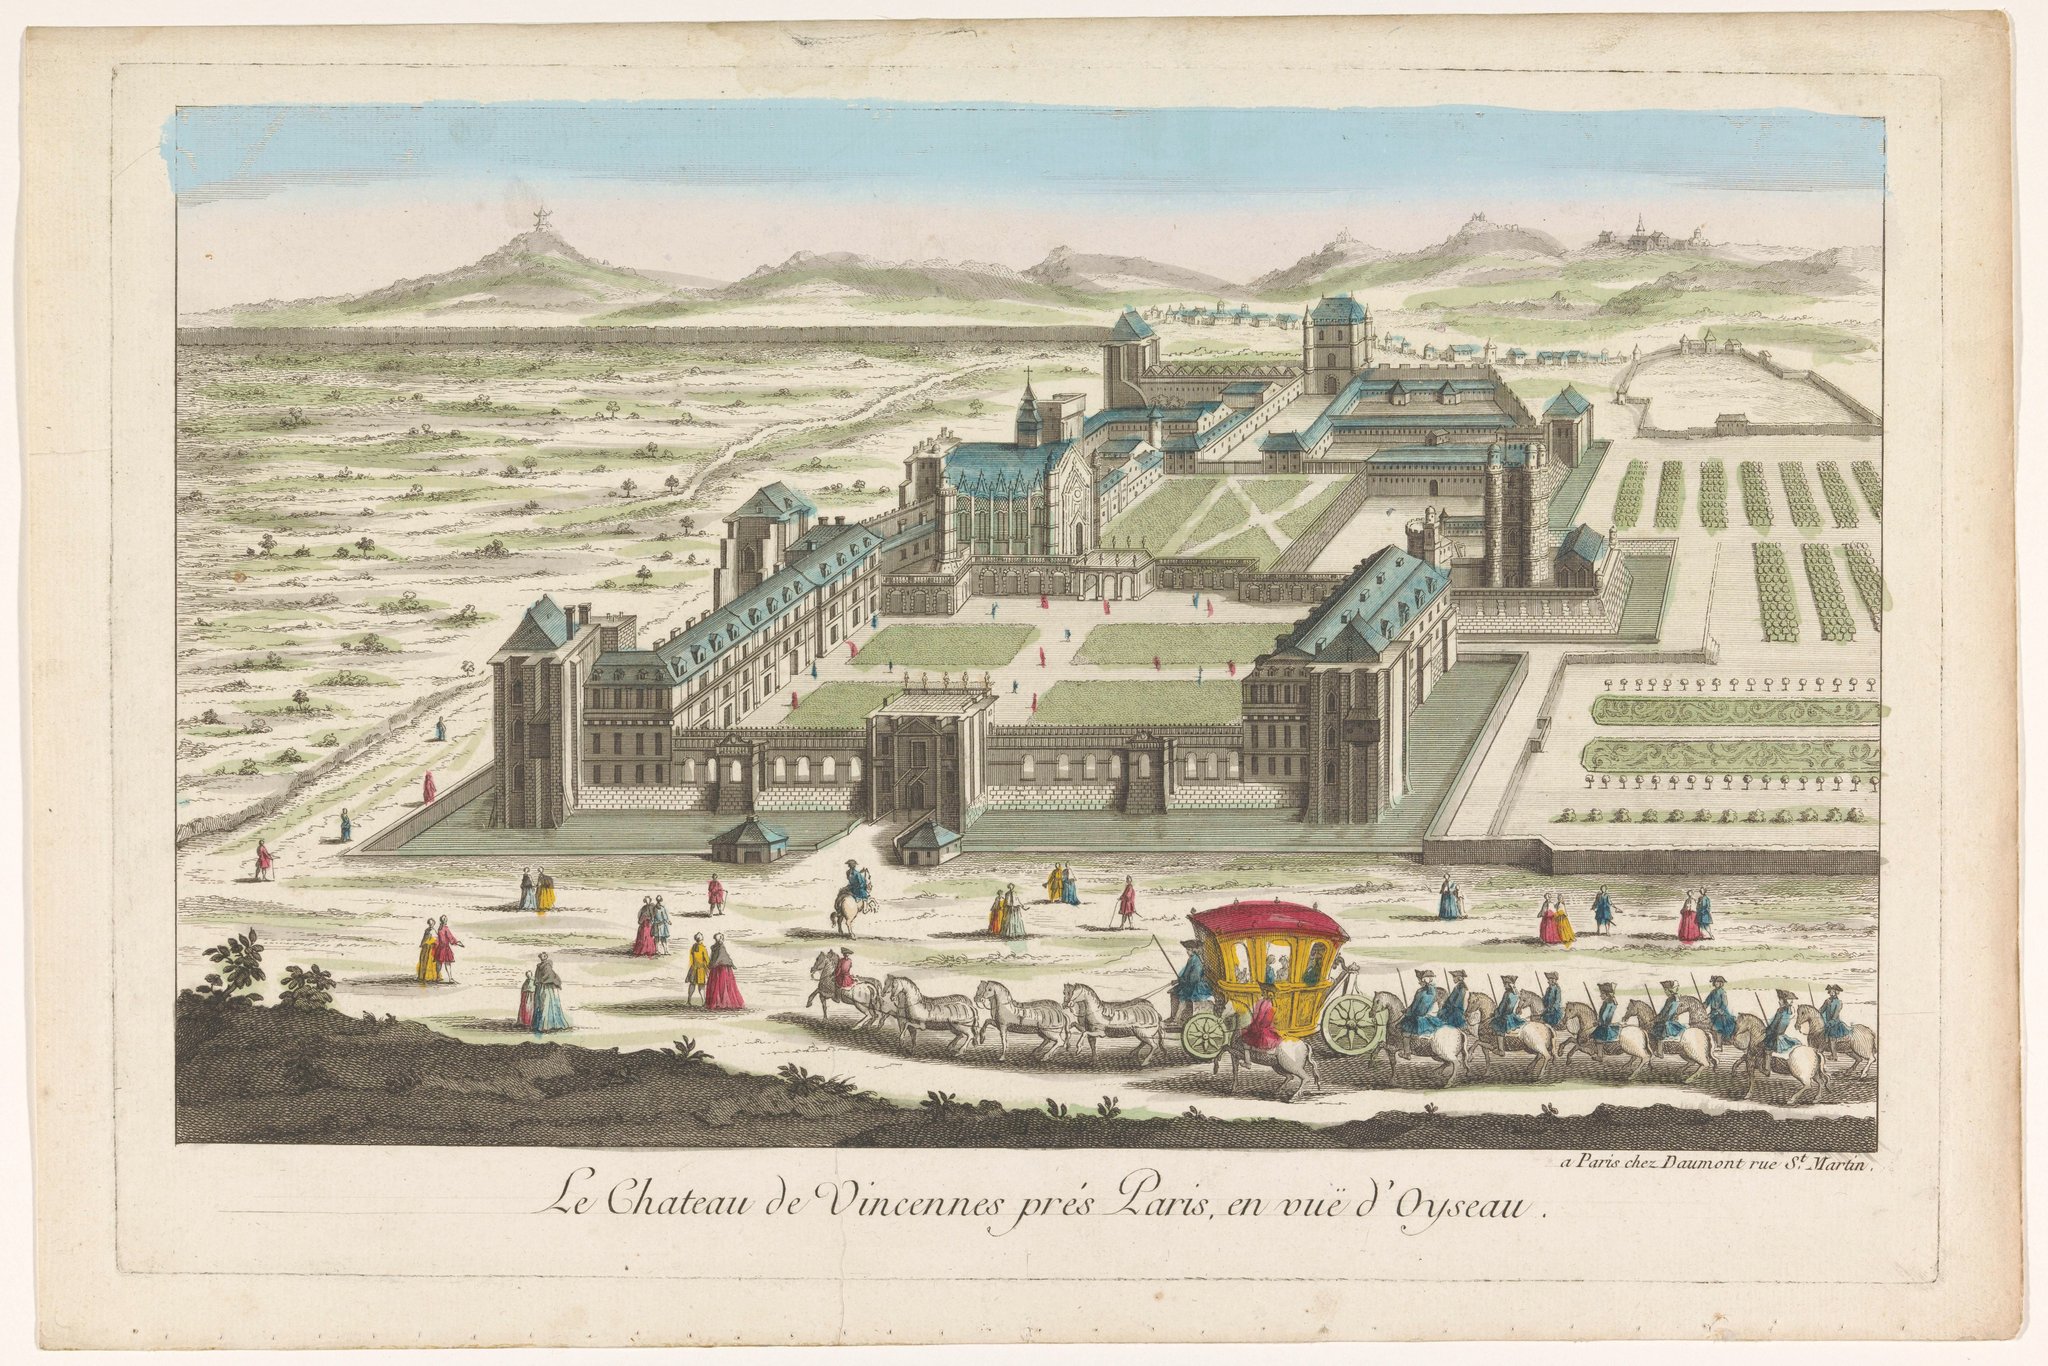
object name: print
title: Gezicht op het Château de Vincennes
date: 1745-1775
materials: paper, watercolor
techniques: brush, etching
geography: france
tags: civic architecture; edifices; dwellings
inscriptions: watermark, collector's mark: Lugt 2166